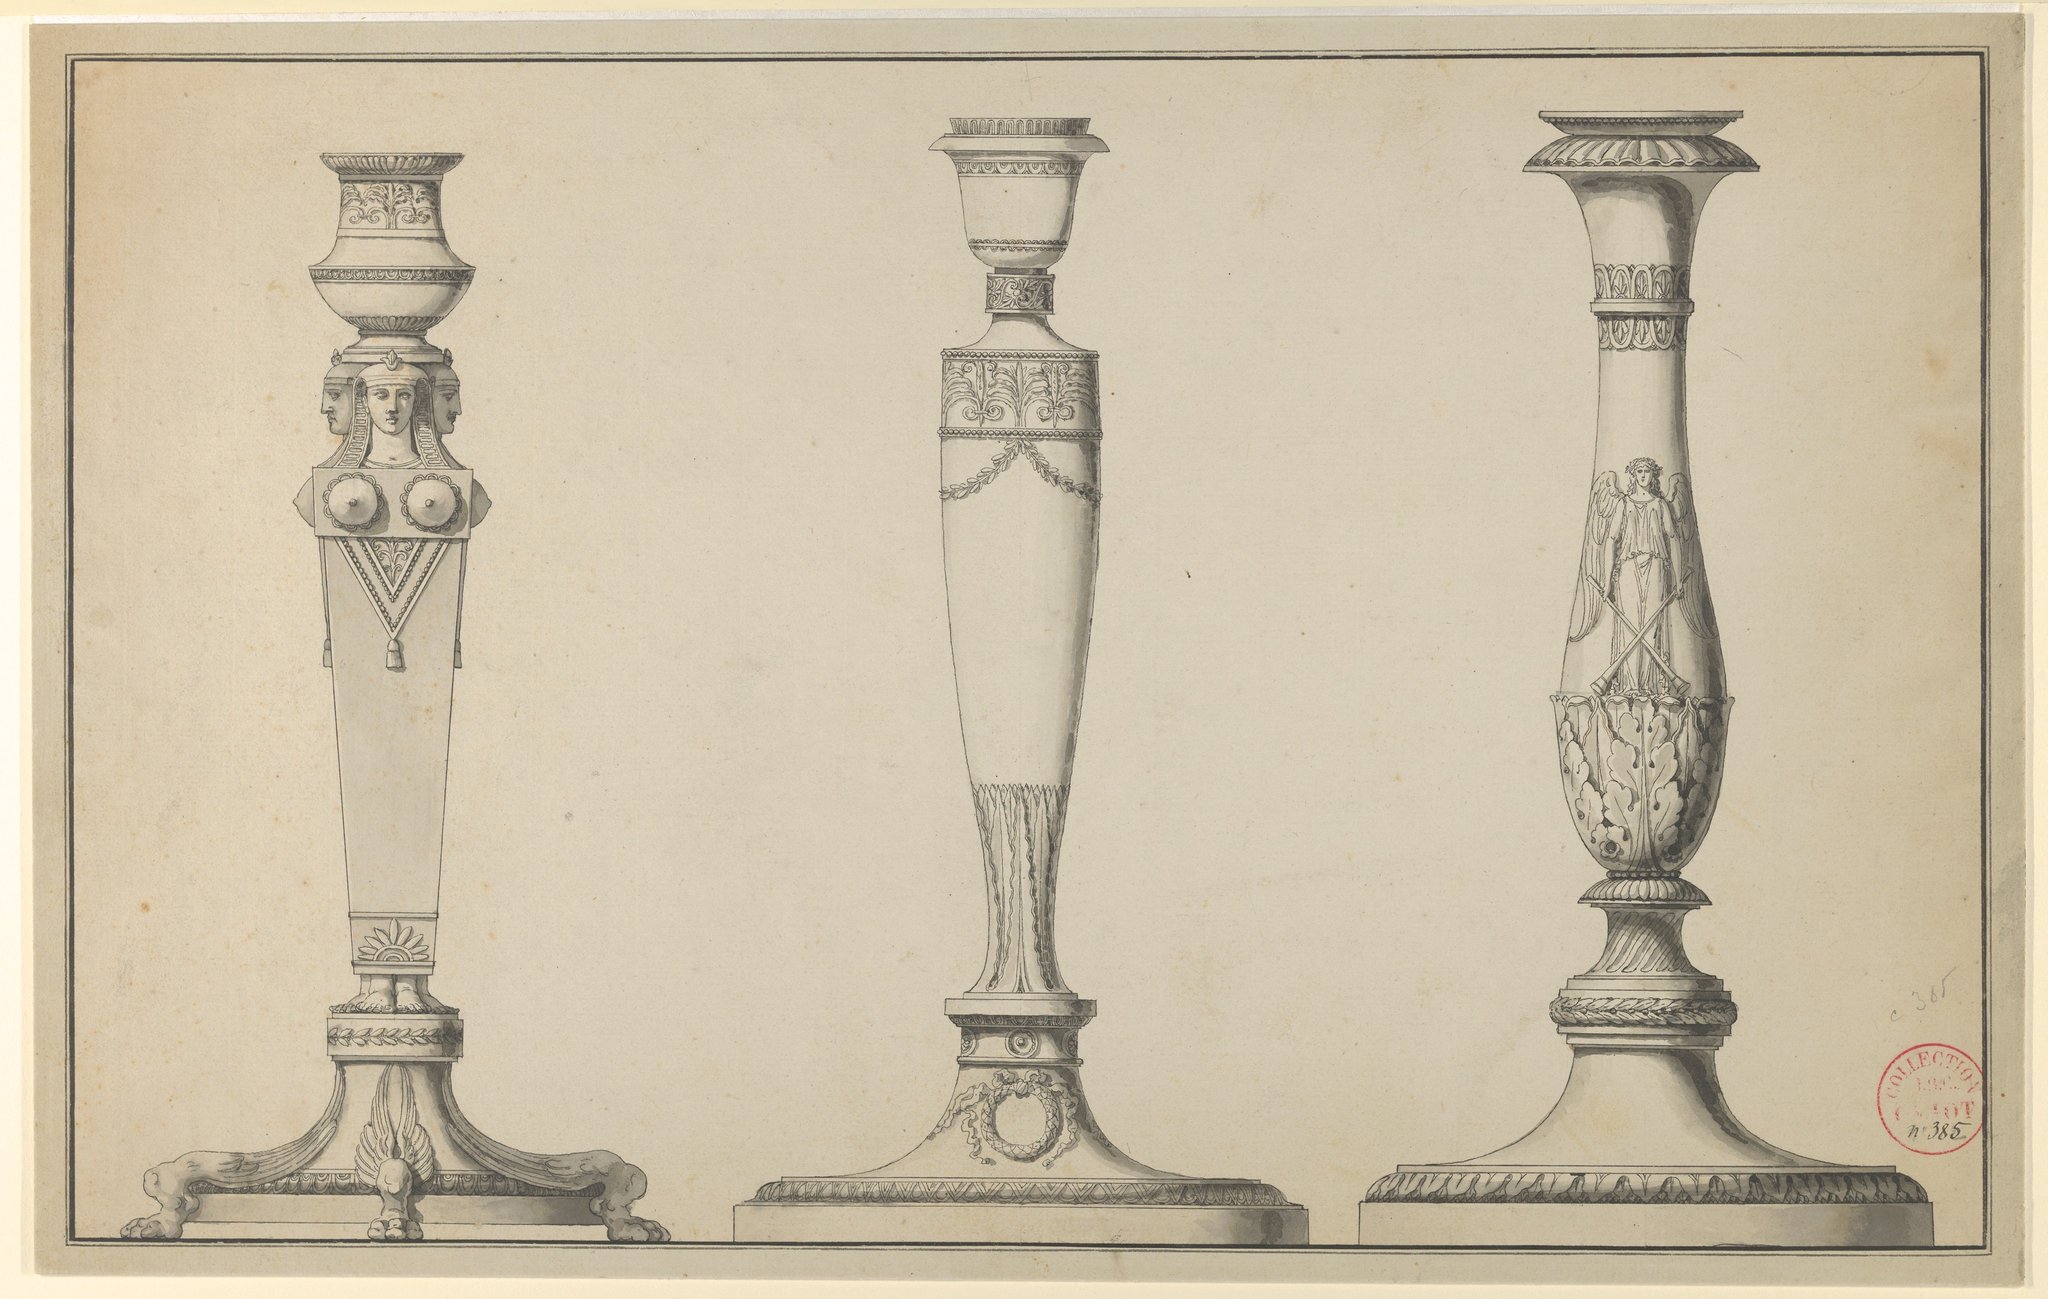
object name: drawing collection ornament architecture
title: Three Designs for Candlesticks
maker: henri auguste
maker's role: artist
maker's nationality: french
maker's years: 1759-1816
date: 1770-1816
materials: ink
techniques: brush, pen, wash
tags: candlesticks